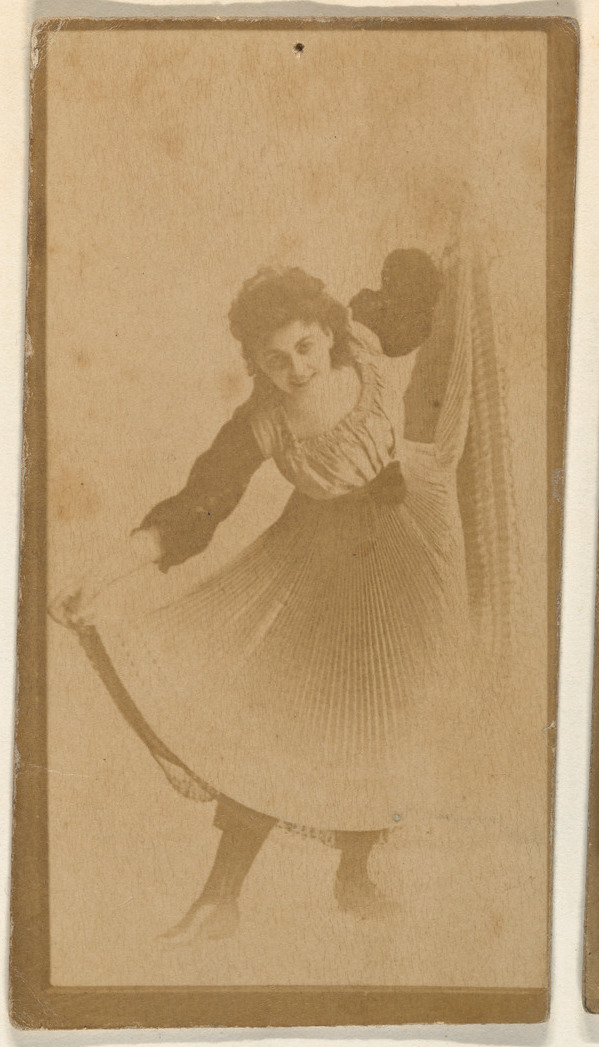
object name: photograph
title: Bowing actress, from the Actresses series (N668)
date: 1888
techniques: albumen silver print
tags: portraits,women,actresses